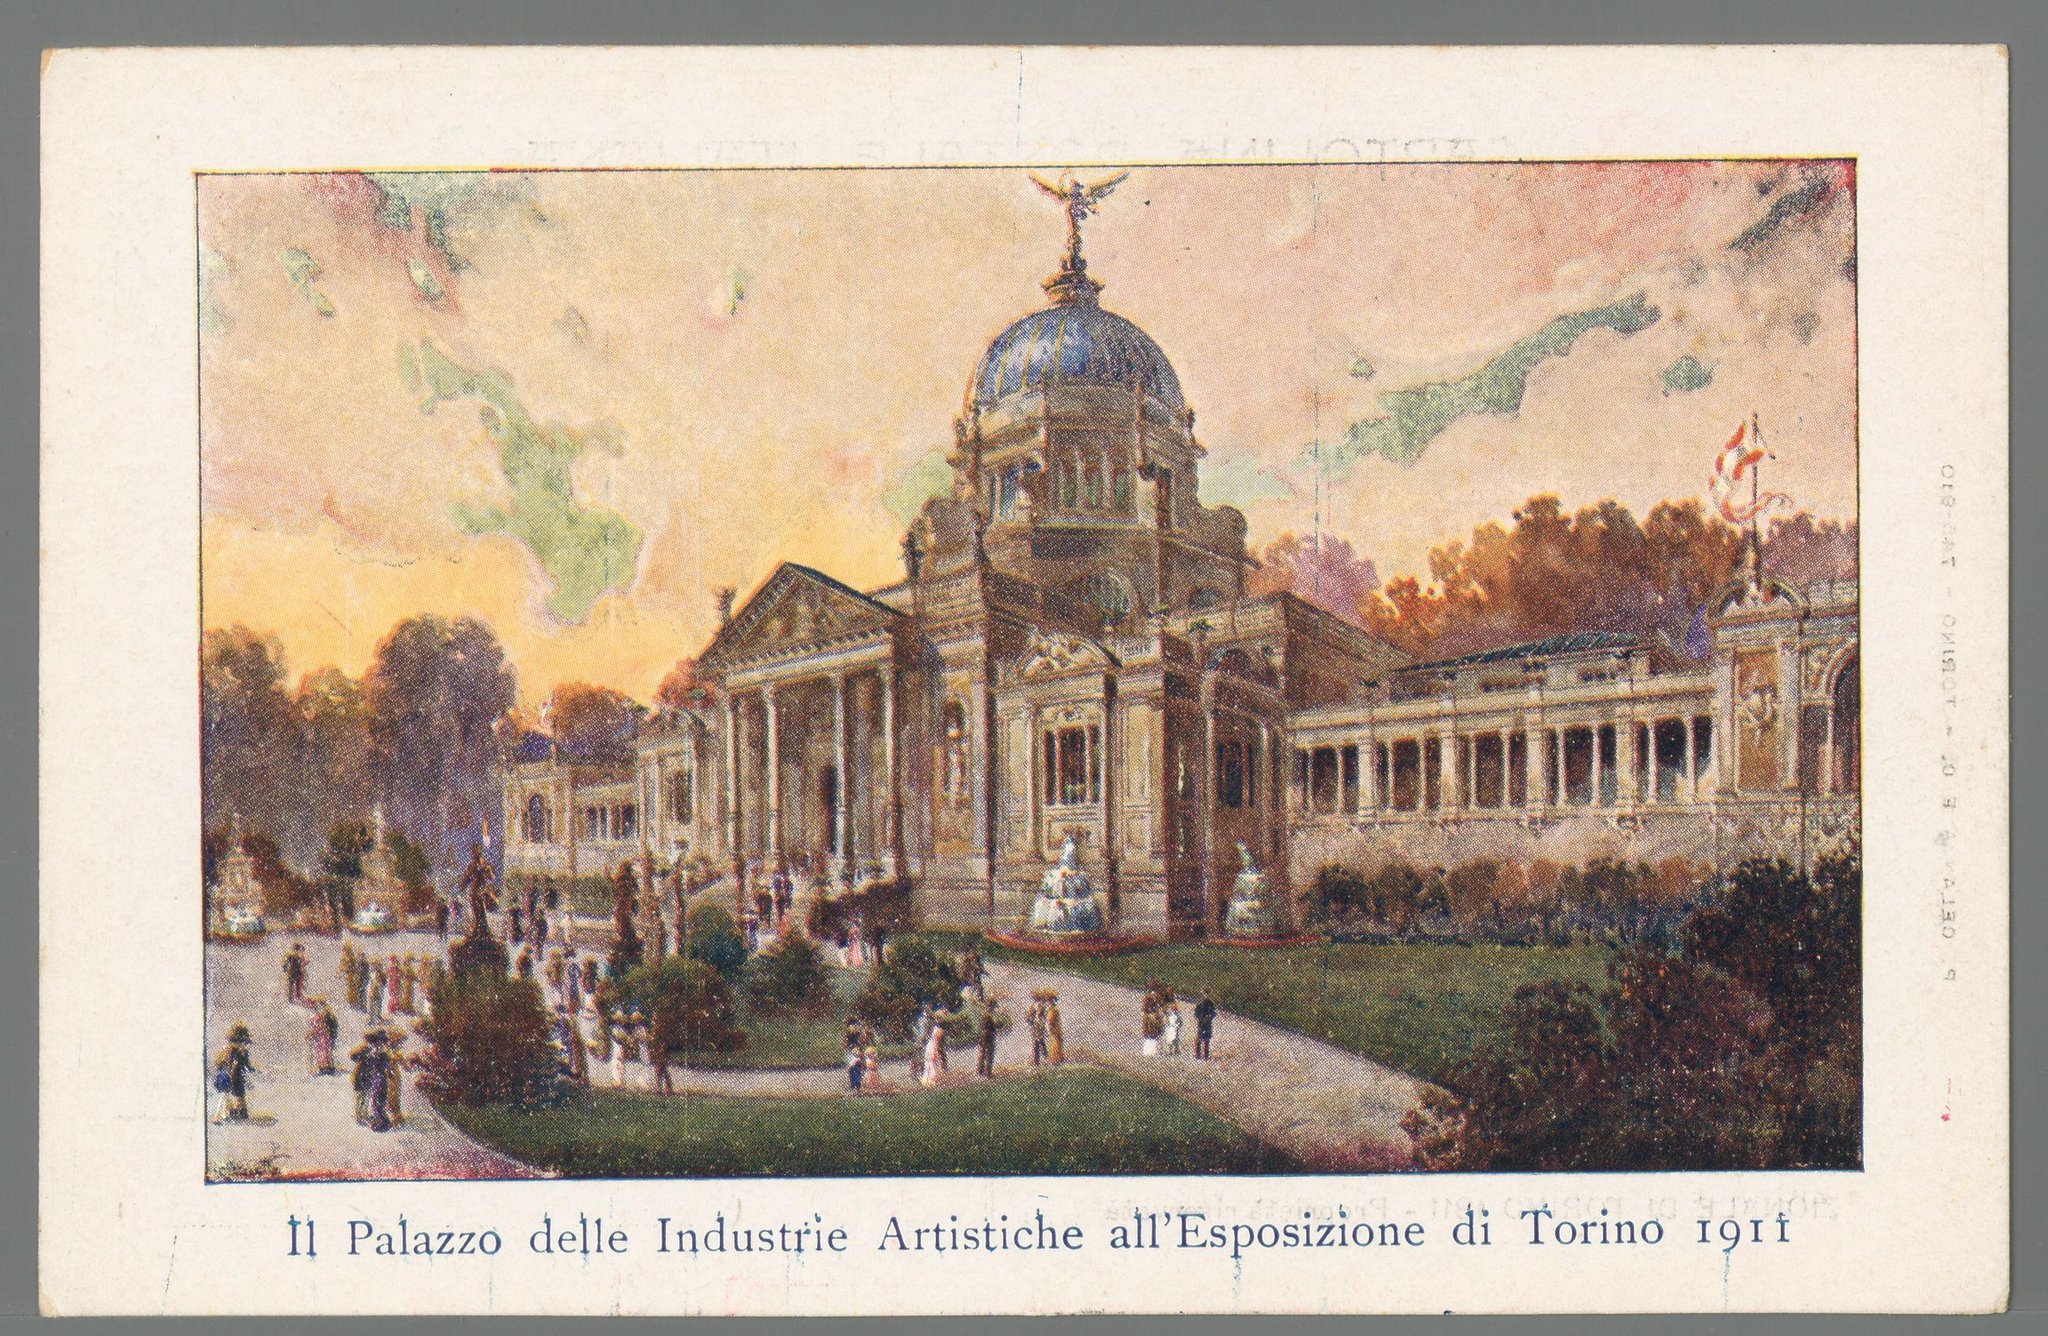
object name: photomechanical print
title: Il Palazzo delle Industrie Artistiche all'Esposizione di Torino 1911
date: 1910-1911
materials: cardboard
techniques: three-color autotype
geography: turin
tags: world fair, world exhibition, palace, public gardens, park, turin international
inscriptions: signature